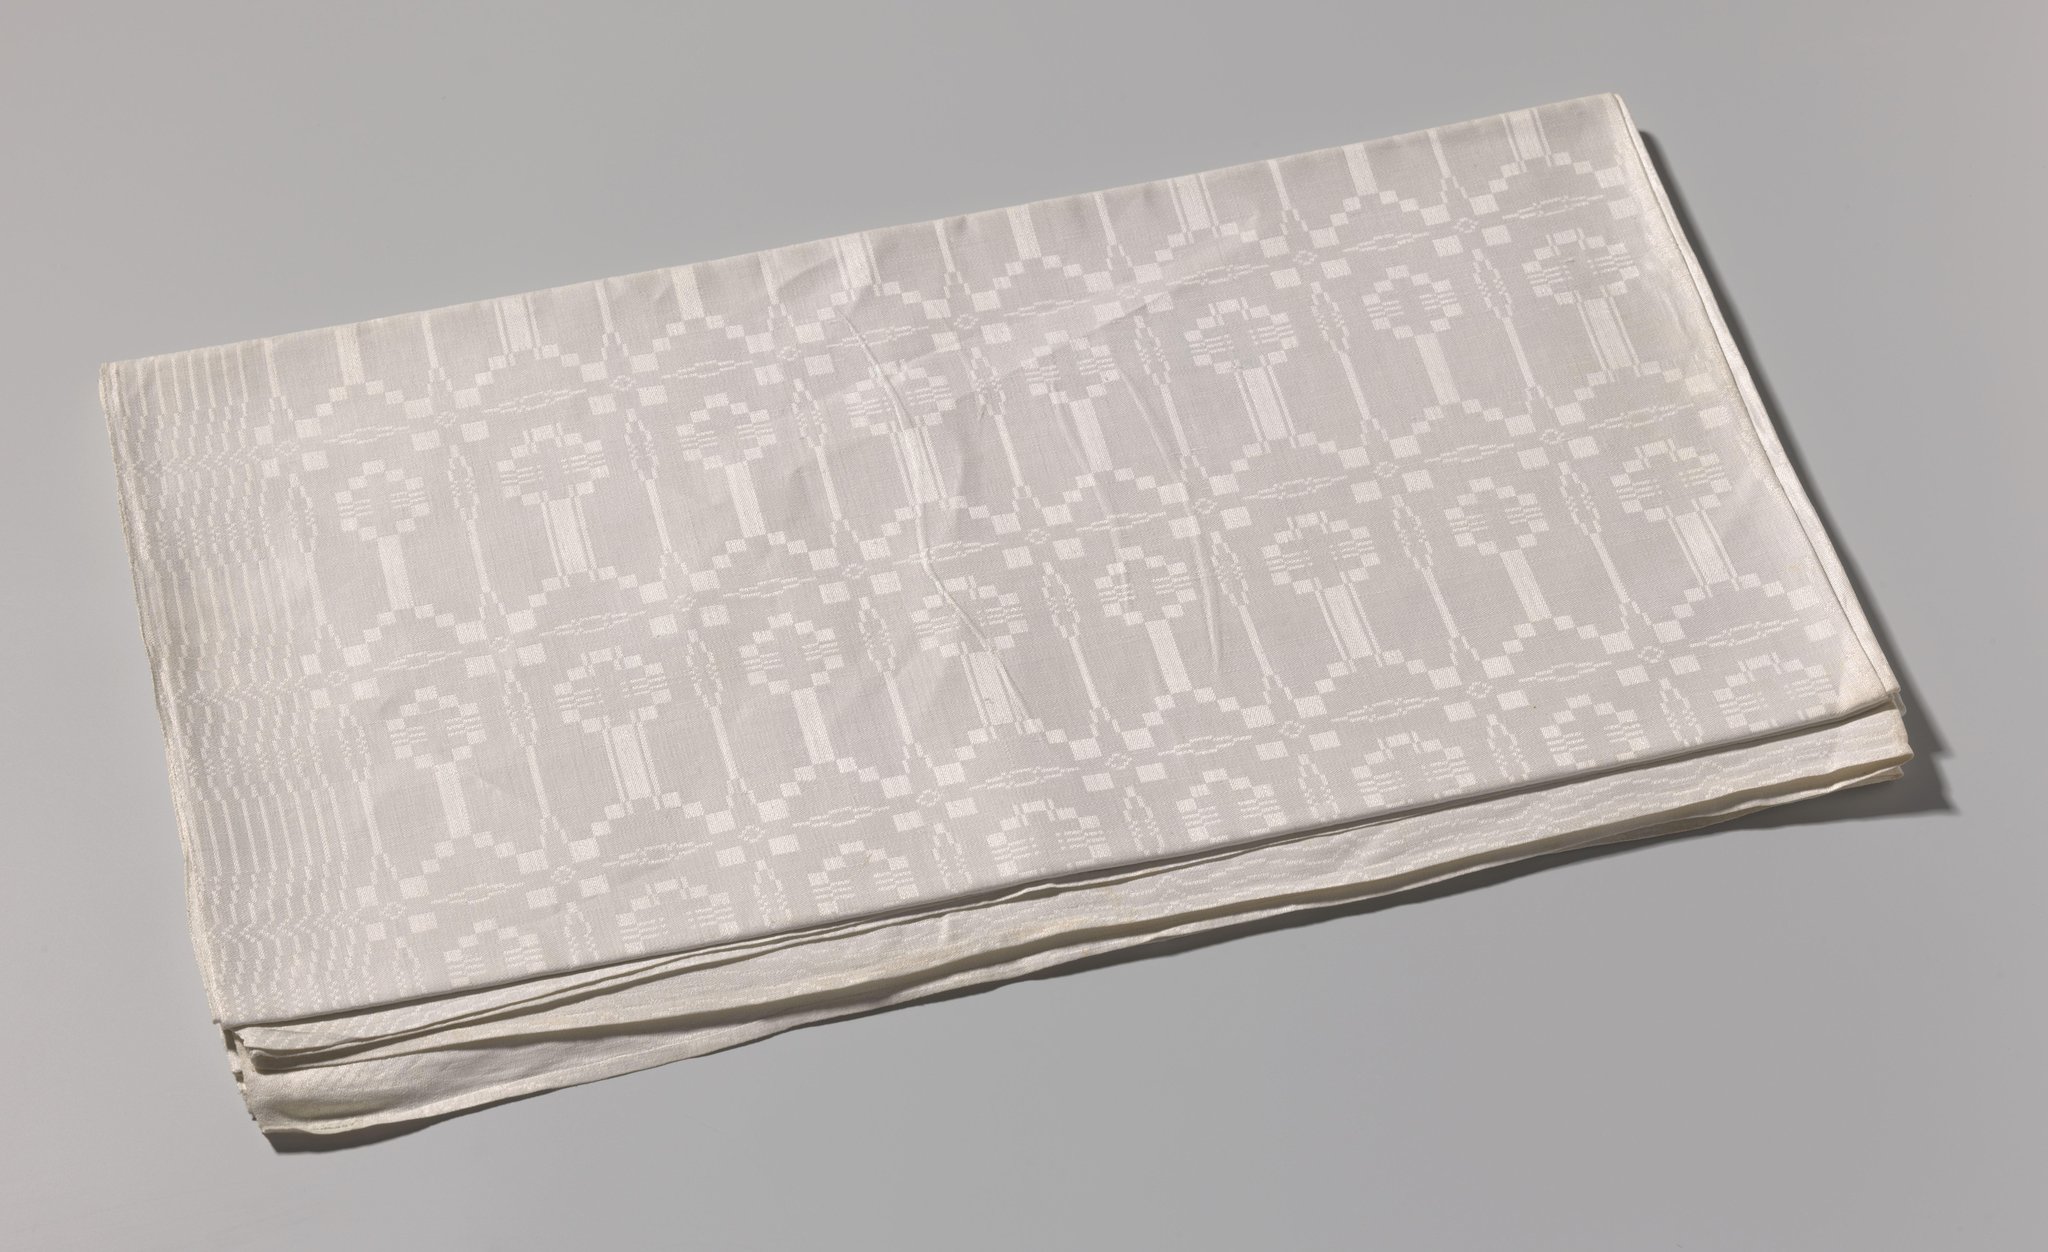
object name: tablecloth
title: Tafellaken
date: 1726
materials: linen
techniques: peeled fabric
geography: northern netherlands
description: Wit linnen tafellaken met een pellen patroon "oranje boom". Merk GS 5.